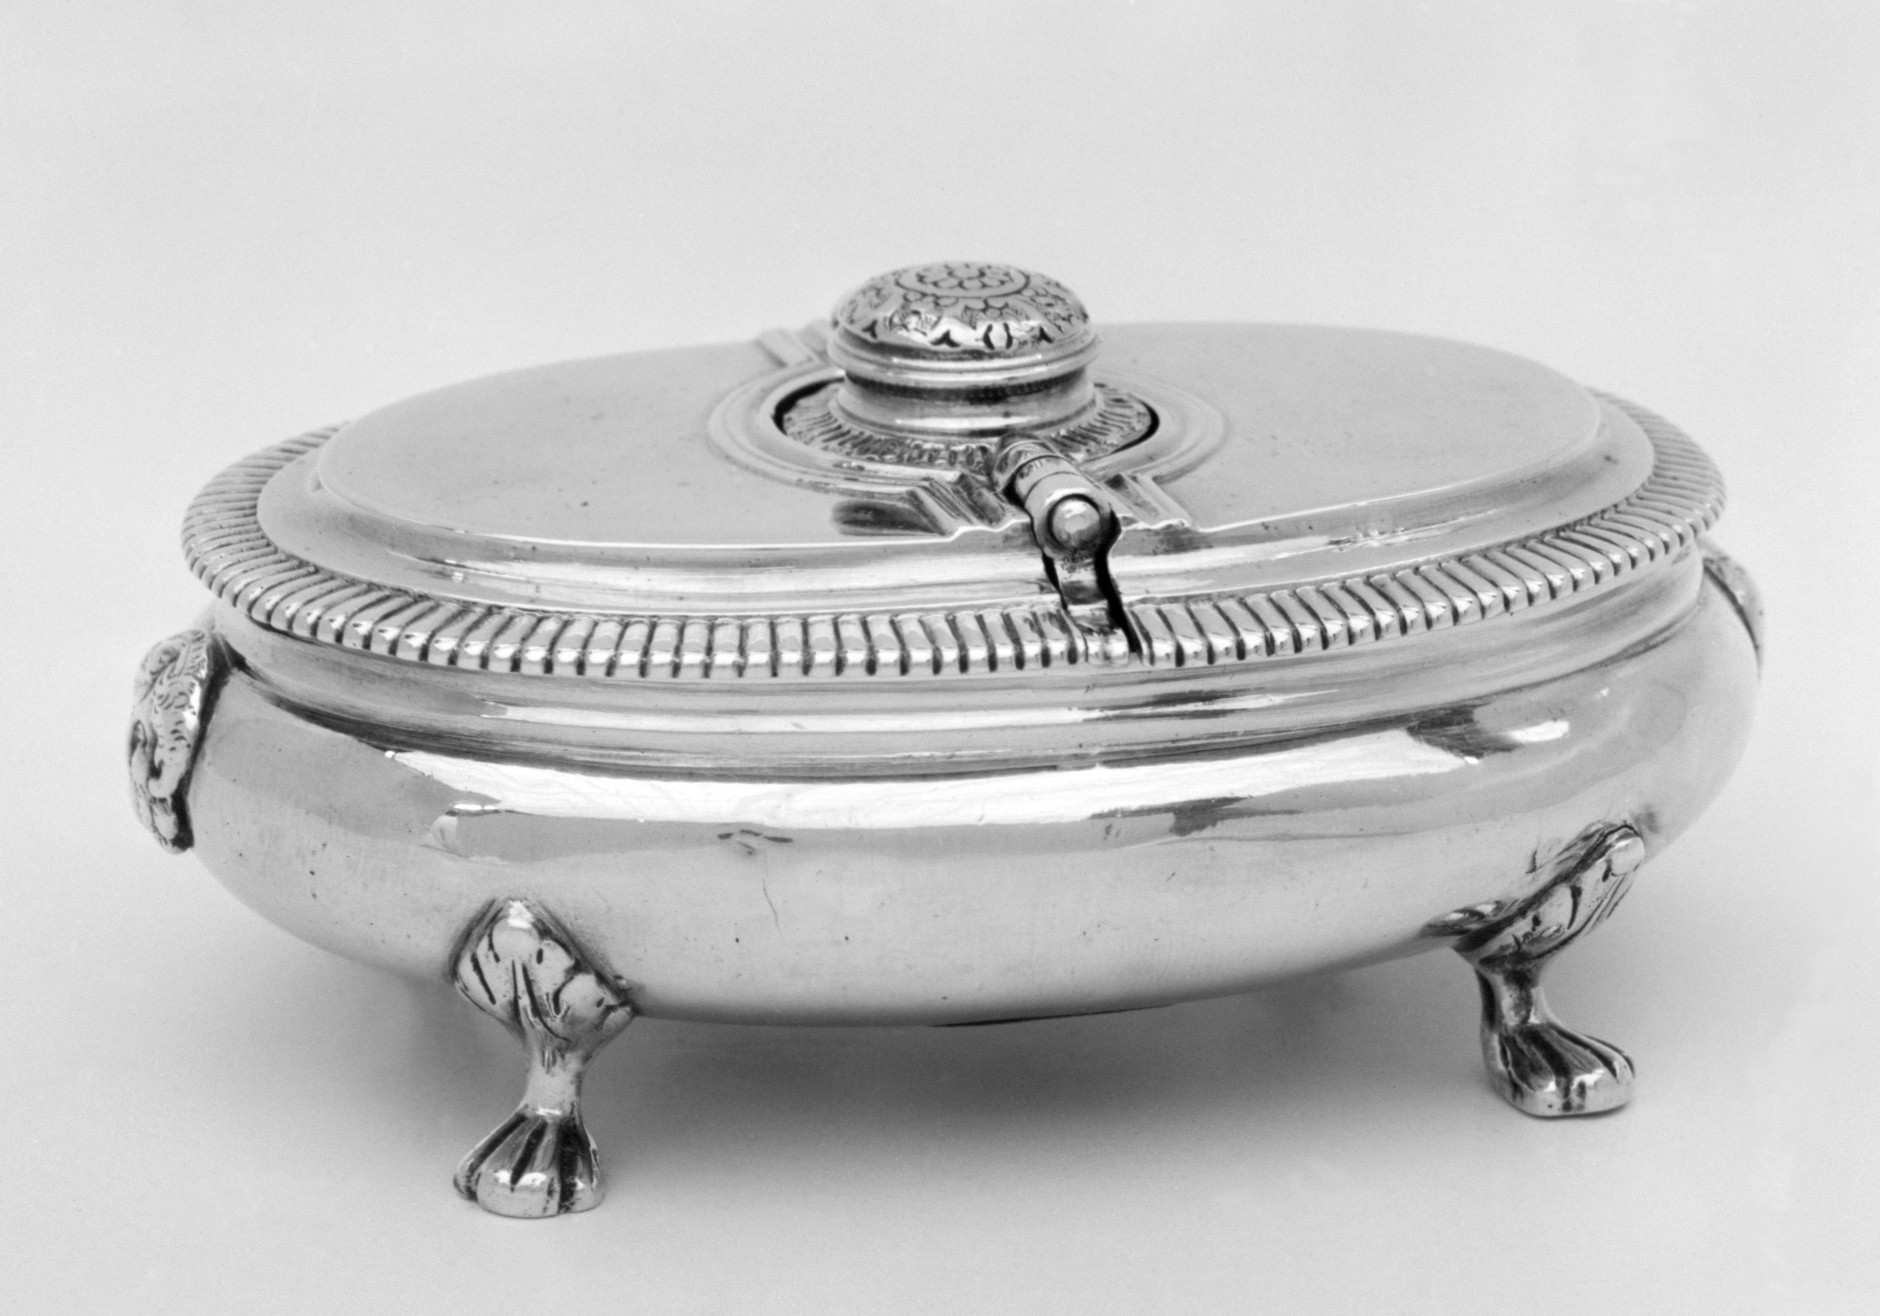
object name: spice box with grater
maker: charles-françois croze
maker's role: maker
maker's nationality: french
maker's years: 1682-1782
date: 1719-1720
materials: silver